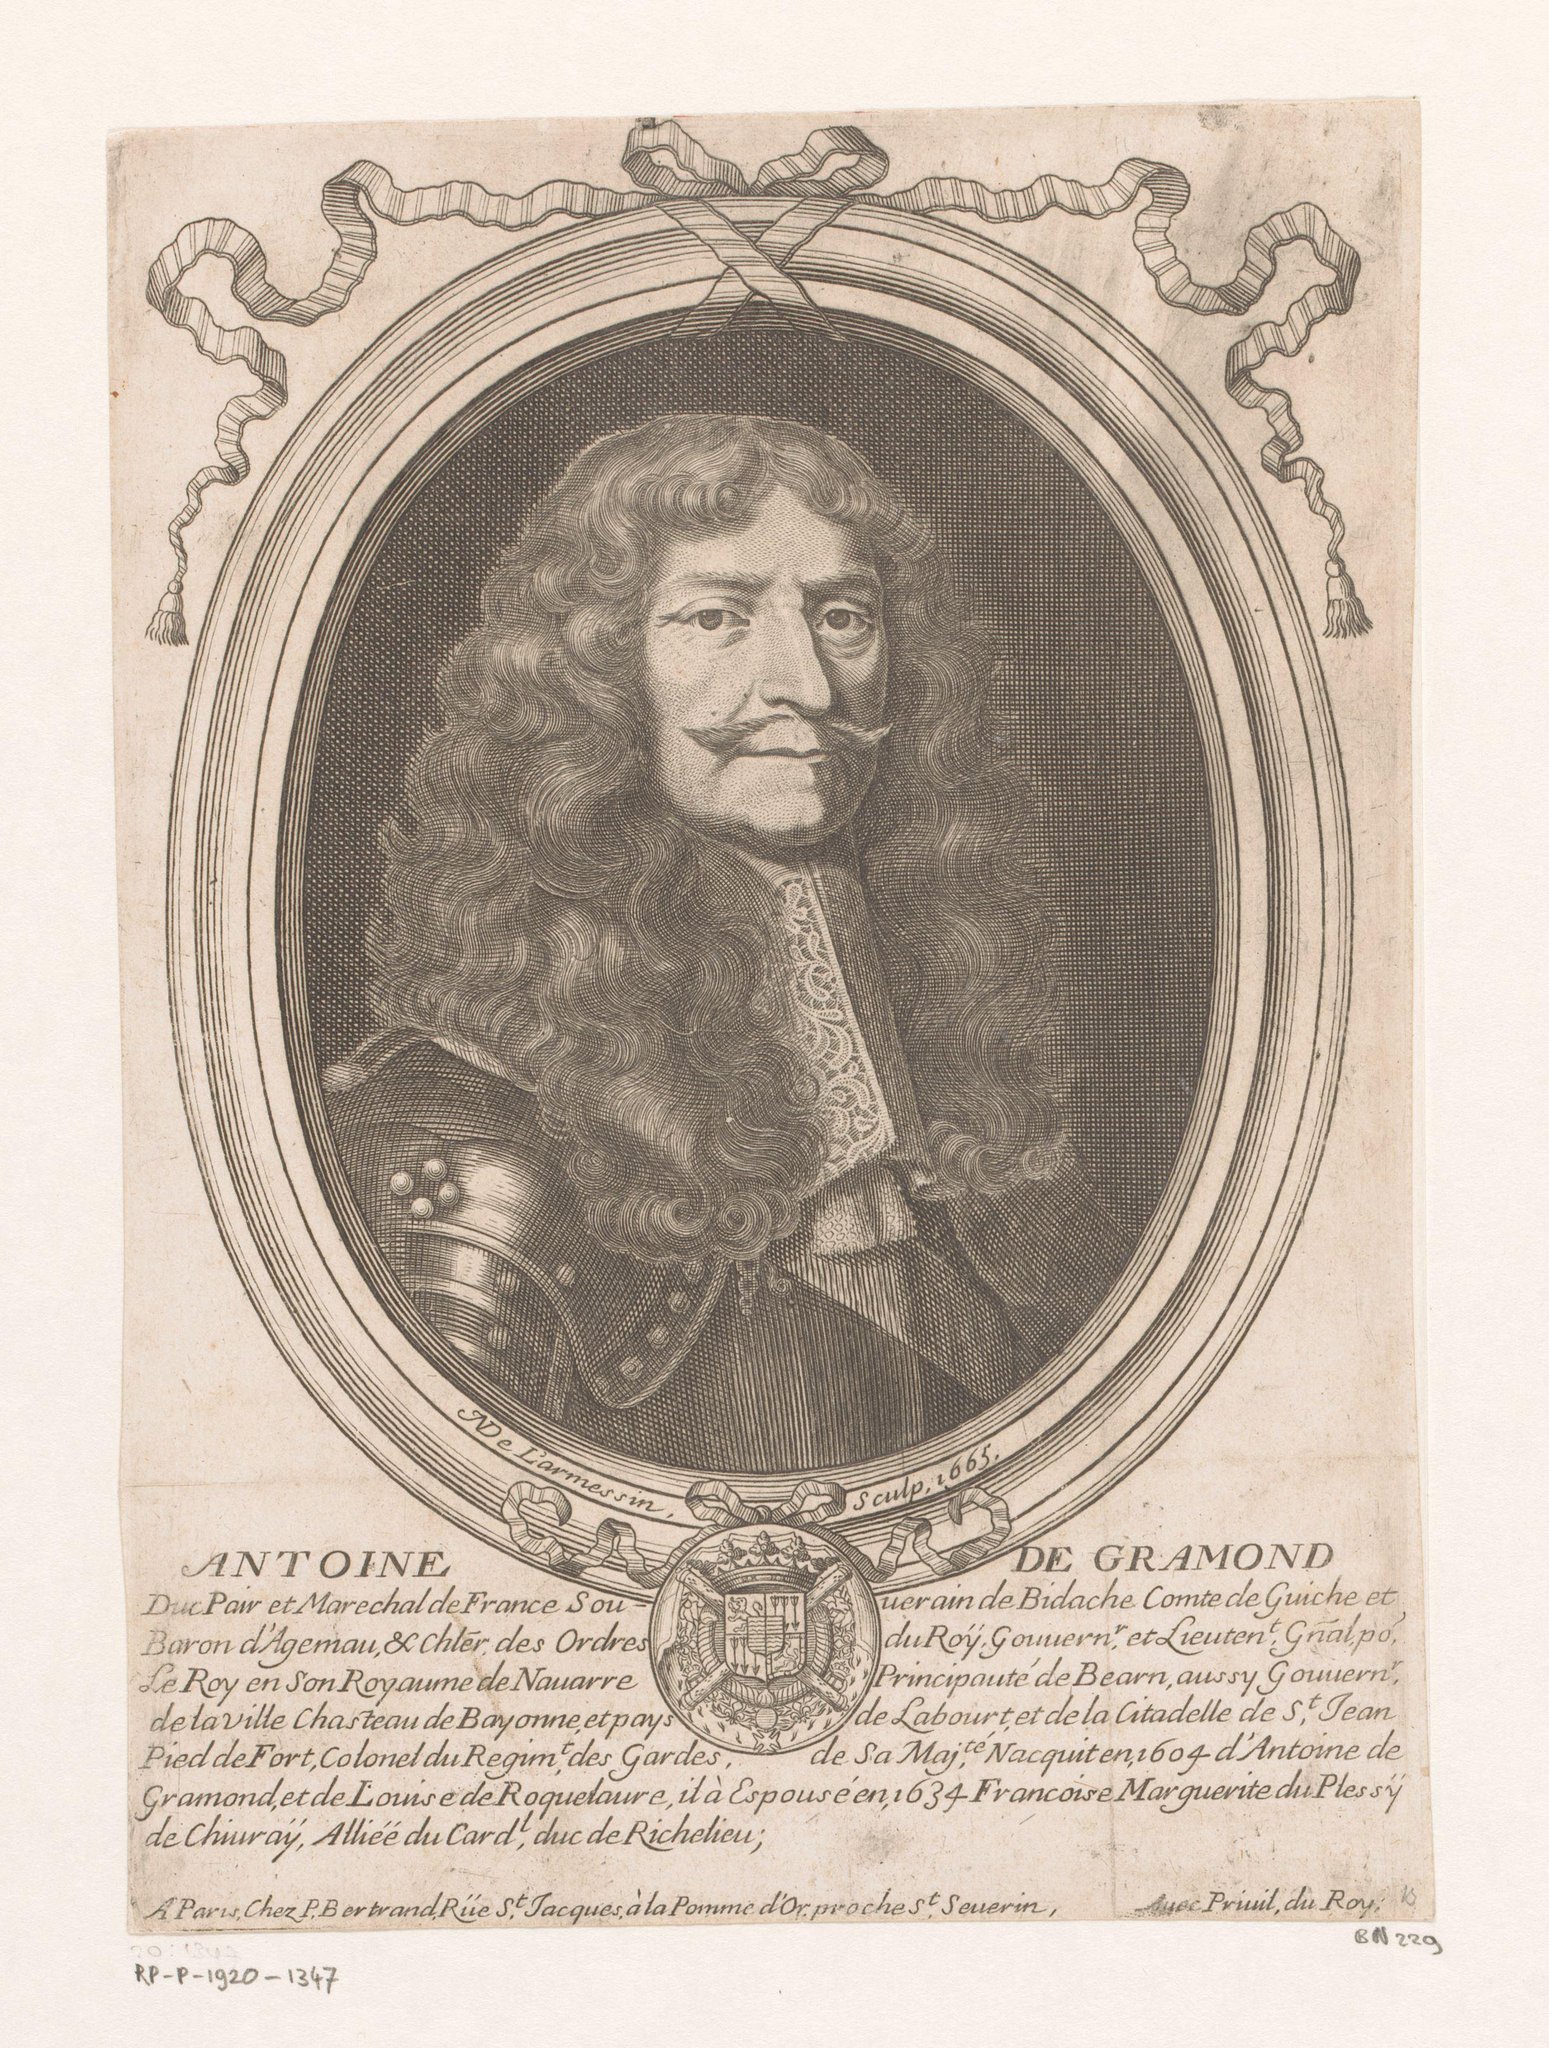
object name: print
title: Portret van Antoine III, hertog van Gramont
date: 1665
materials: paper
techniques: engraving, etching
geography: france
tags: historical persons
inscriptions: collector's mark: Lugt 2228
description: Maakt deel uit van een grootschalige serie met portretten van prominente figuren. Binnen de serie bevindt zich een sectie getiteld 'Les Augustes Représentations De tous les Roys De France depuis Pharamond Iusqu'à Louys XIIII'. De serie werd respectievelijk uitgegeven door Pierre Bertrand, door zijn weduwe en door De Larmessin zelf.